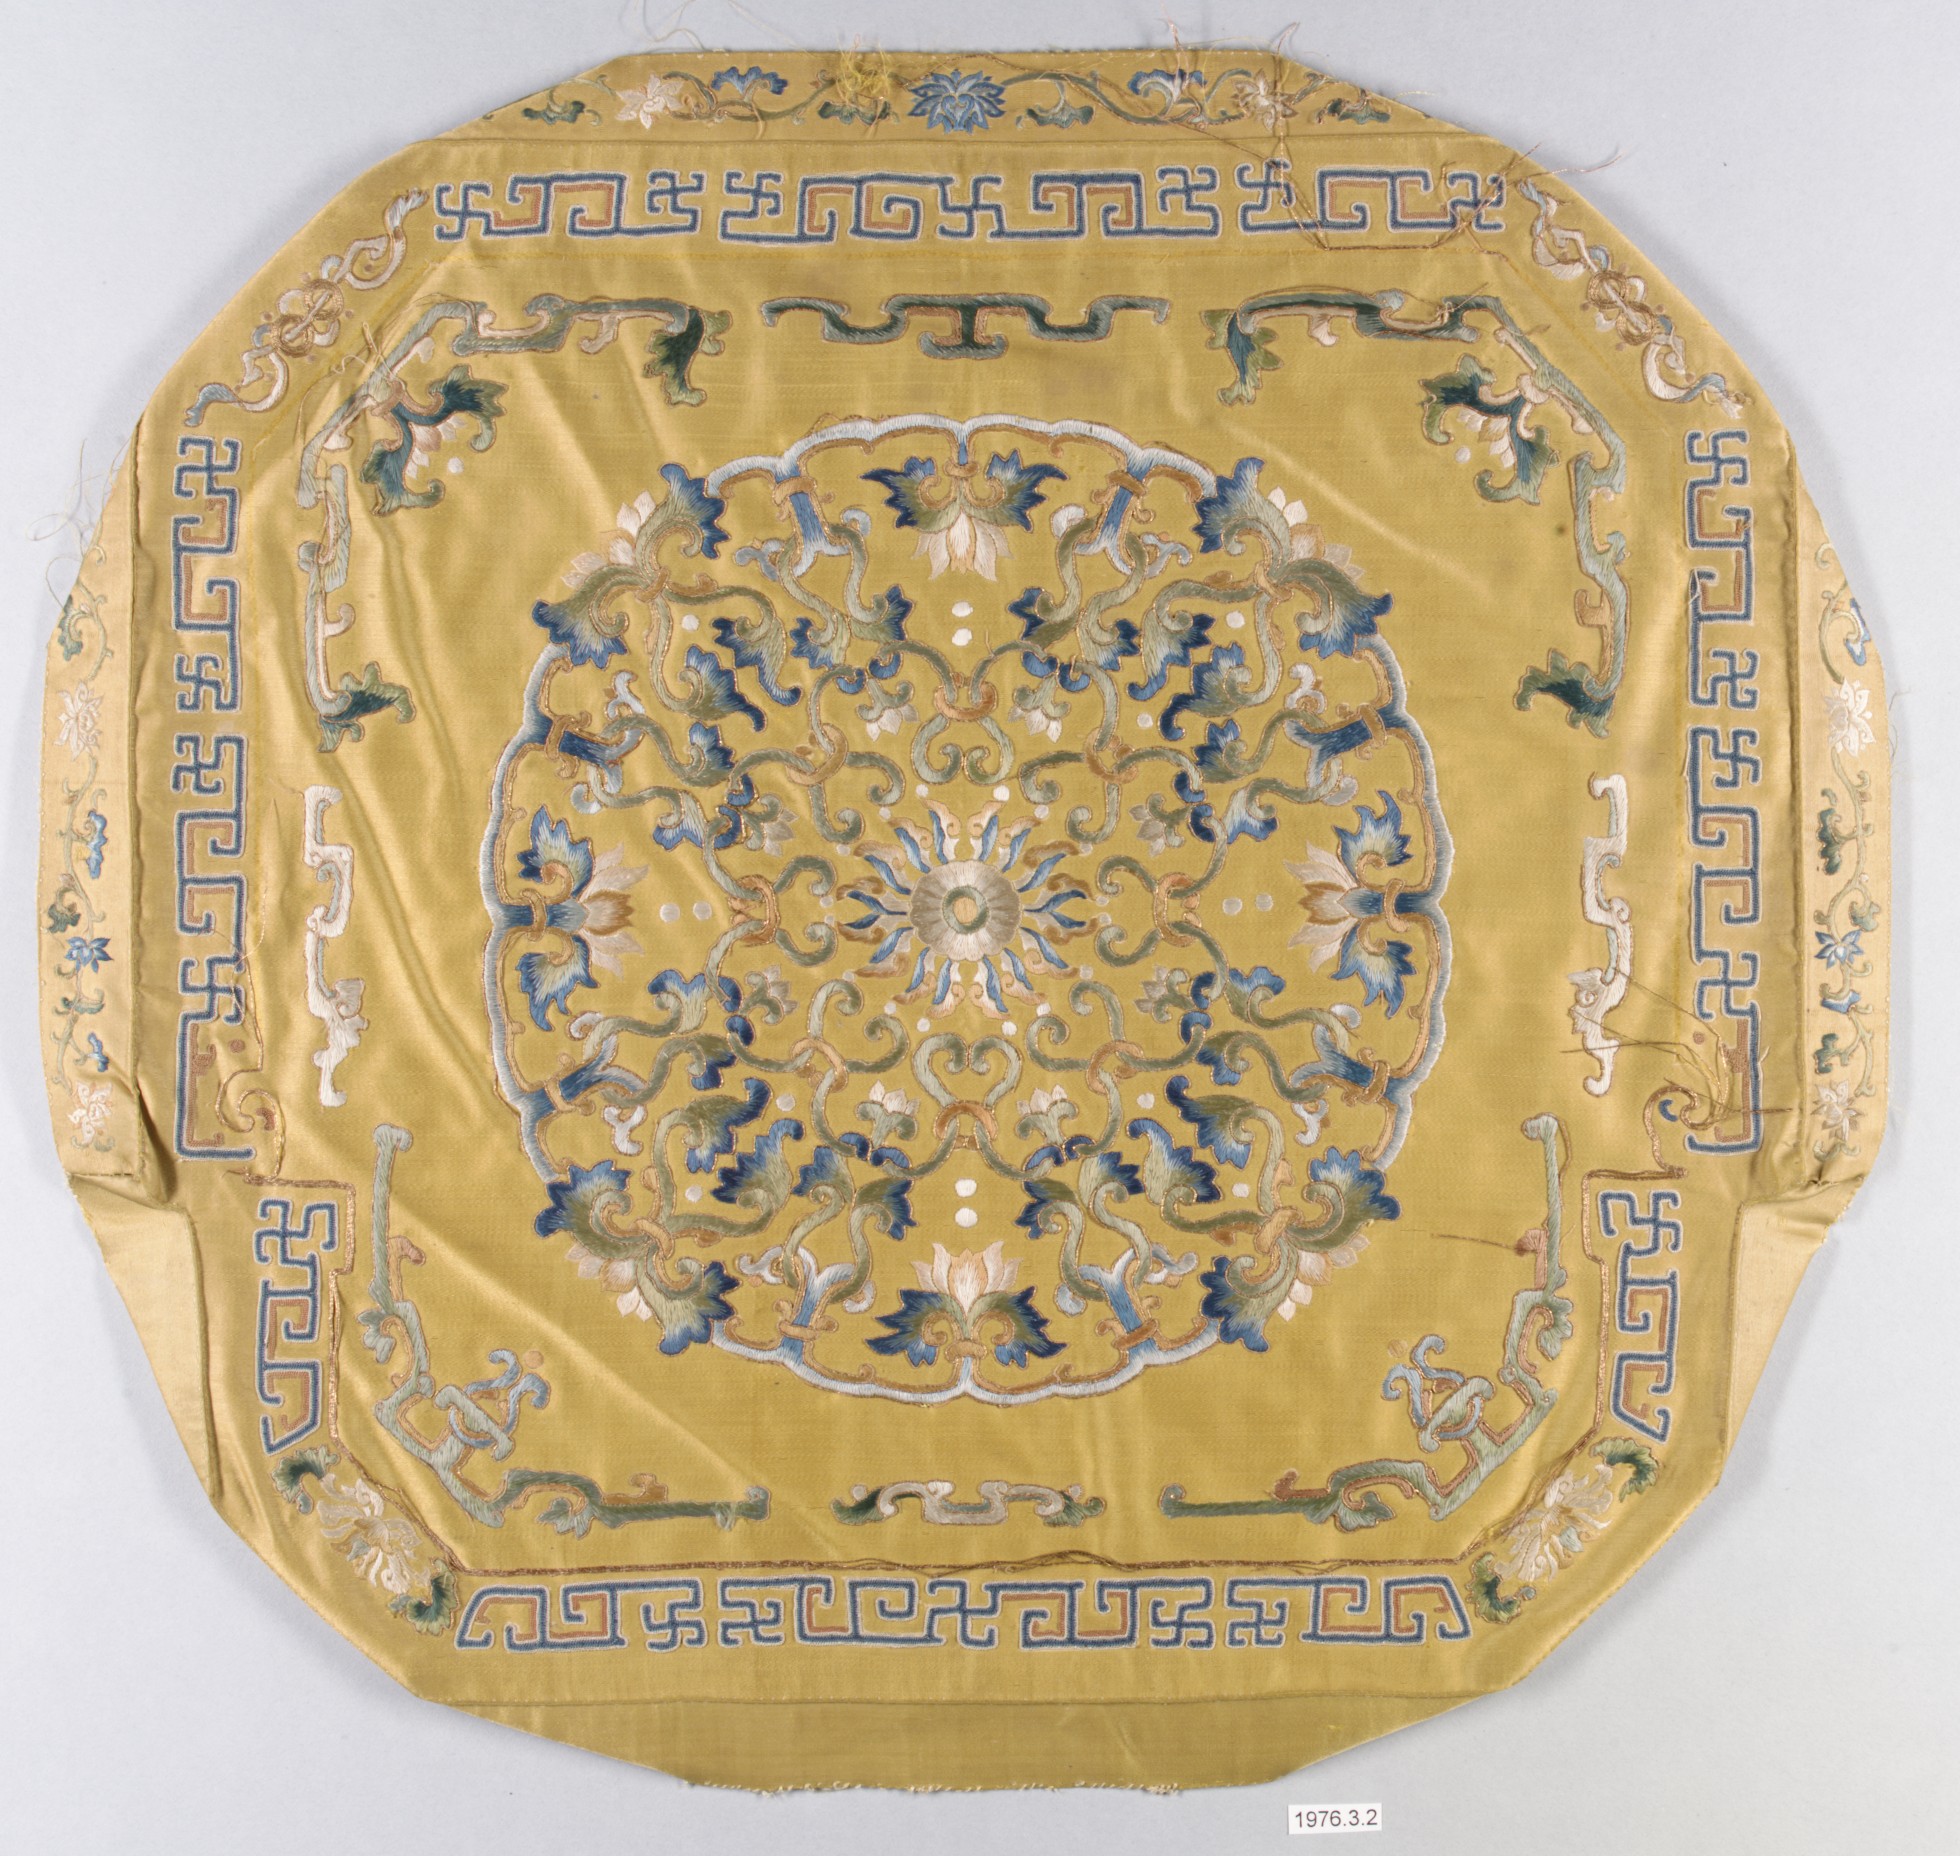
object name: cushion cover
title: Cushion Cover for Chair Pad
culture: chinese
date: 1736-1795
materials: metal thread, silk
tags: flowers